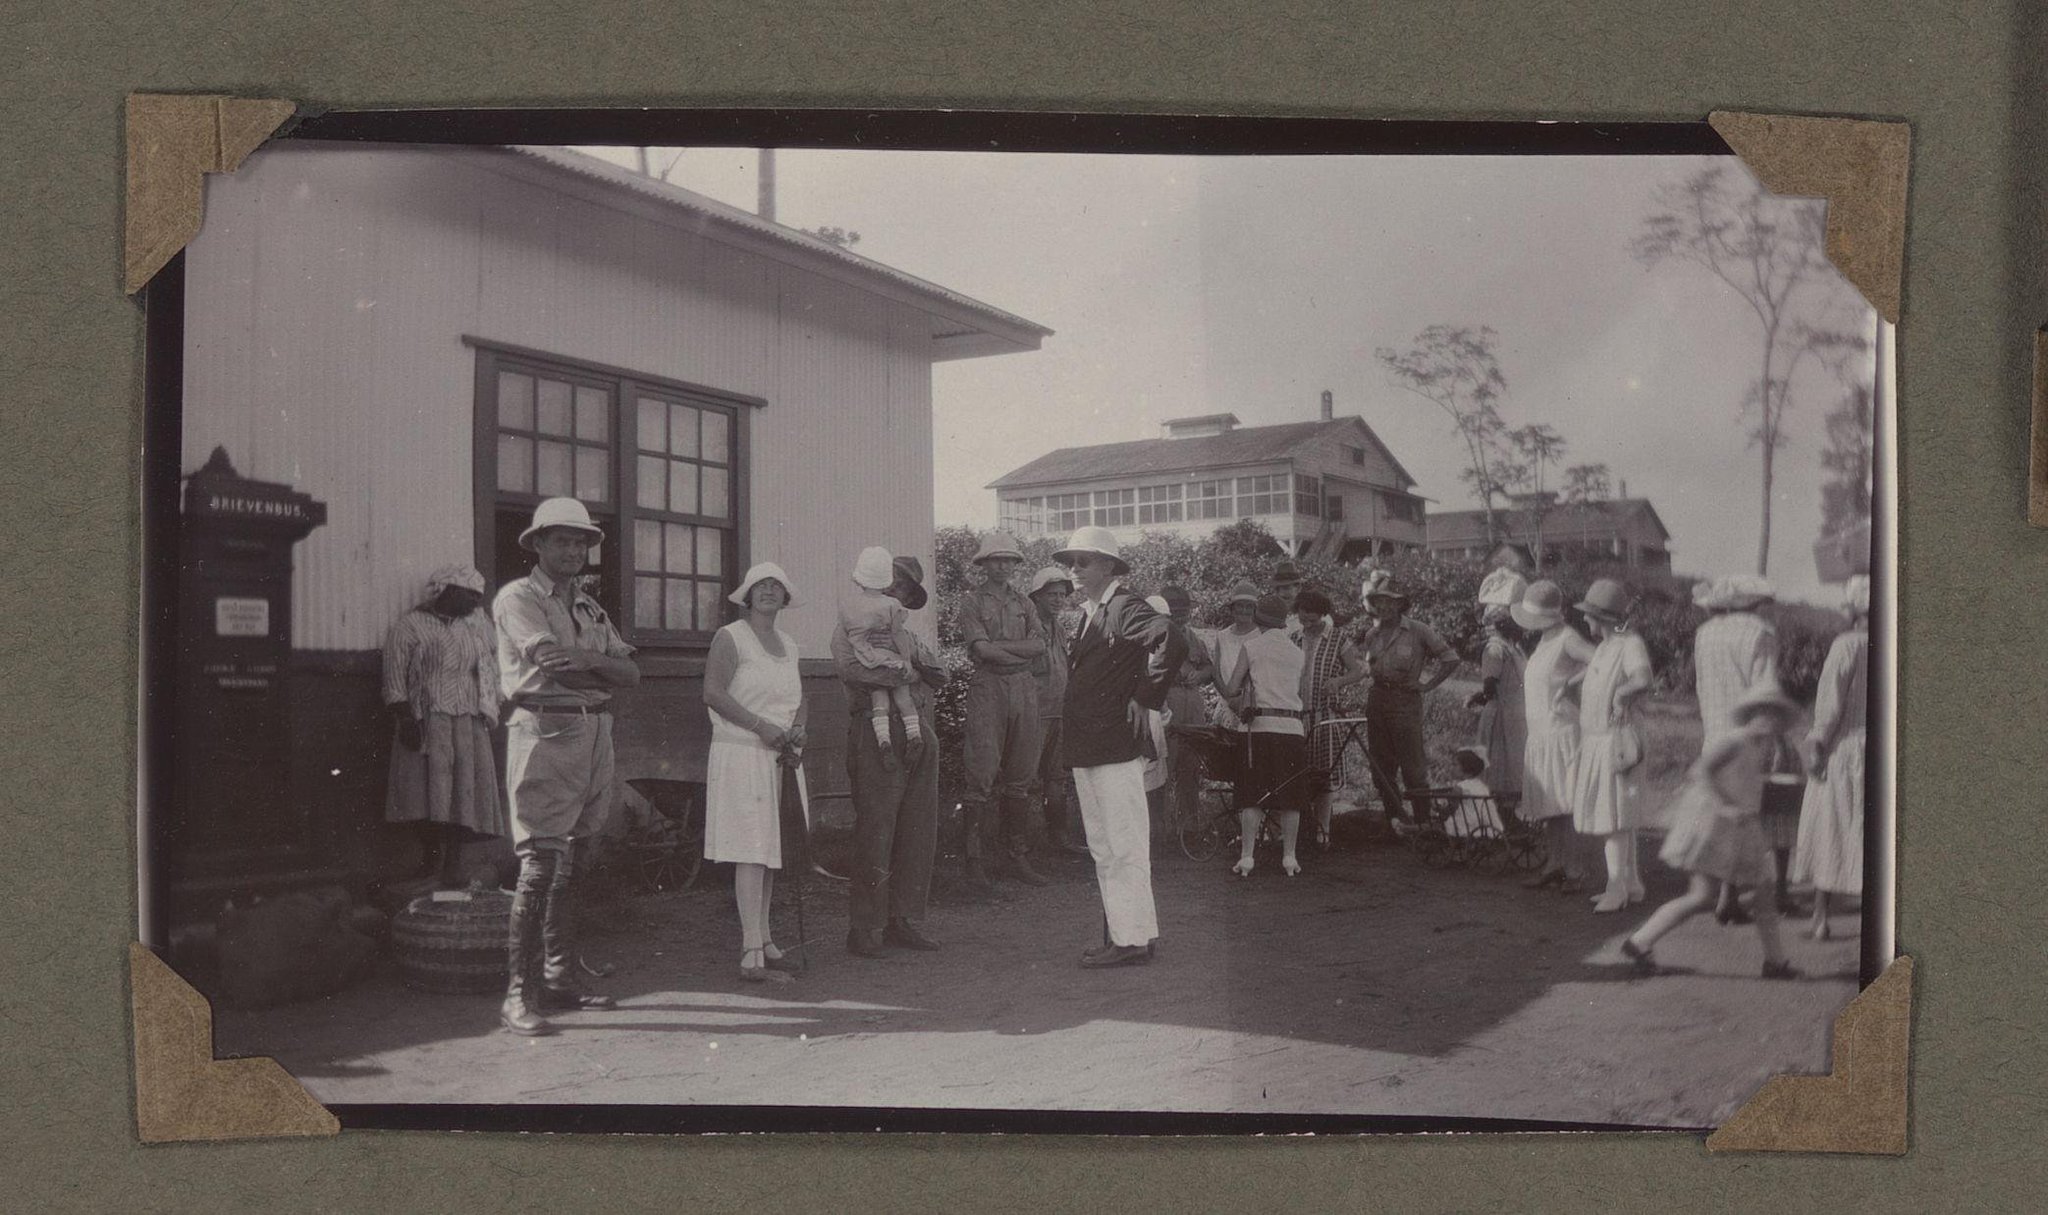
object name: photograph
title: Familiefoto van het gezin Jetten te Moengo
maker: Anonymous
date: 1925-1927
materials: photographic support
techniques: photography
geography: suriname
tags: jetten, familie, moengo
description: Familiefoto van het gezin Jetten te Moengo. Foto op een bladzijde van een los albumblad. Onderdeel van het ensemble met foto's van de familie van ingenieur Jetten in de mijnbouwstad Moengo in Suriname.